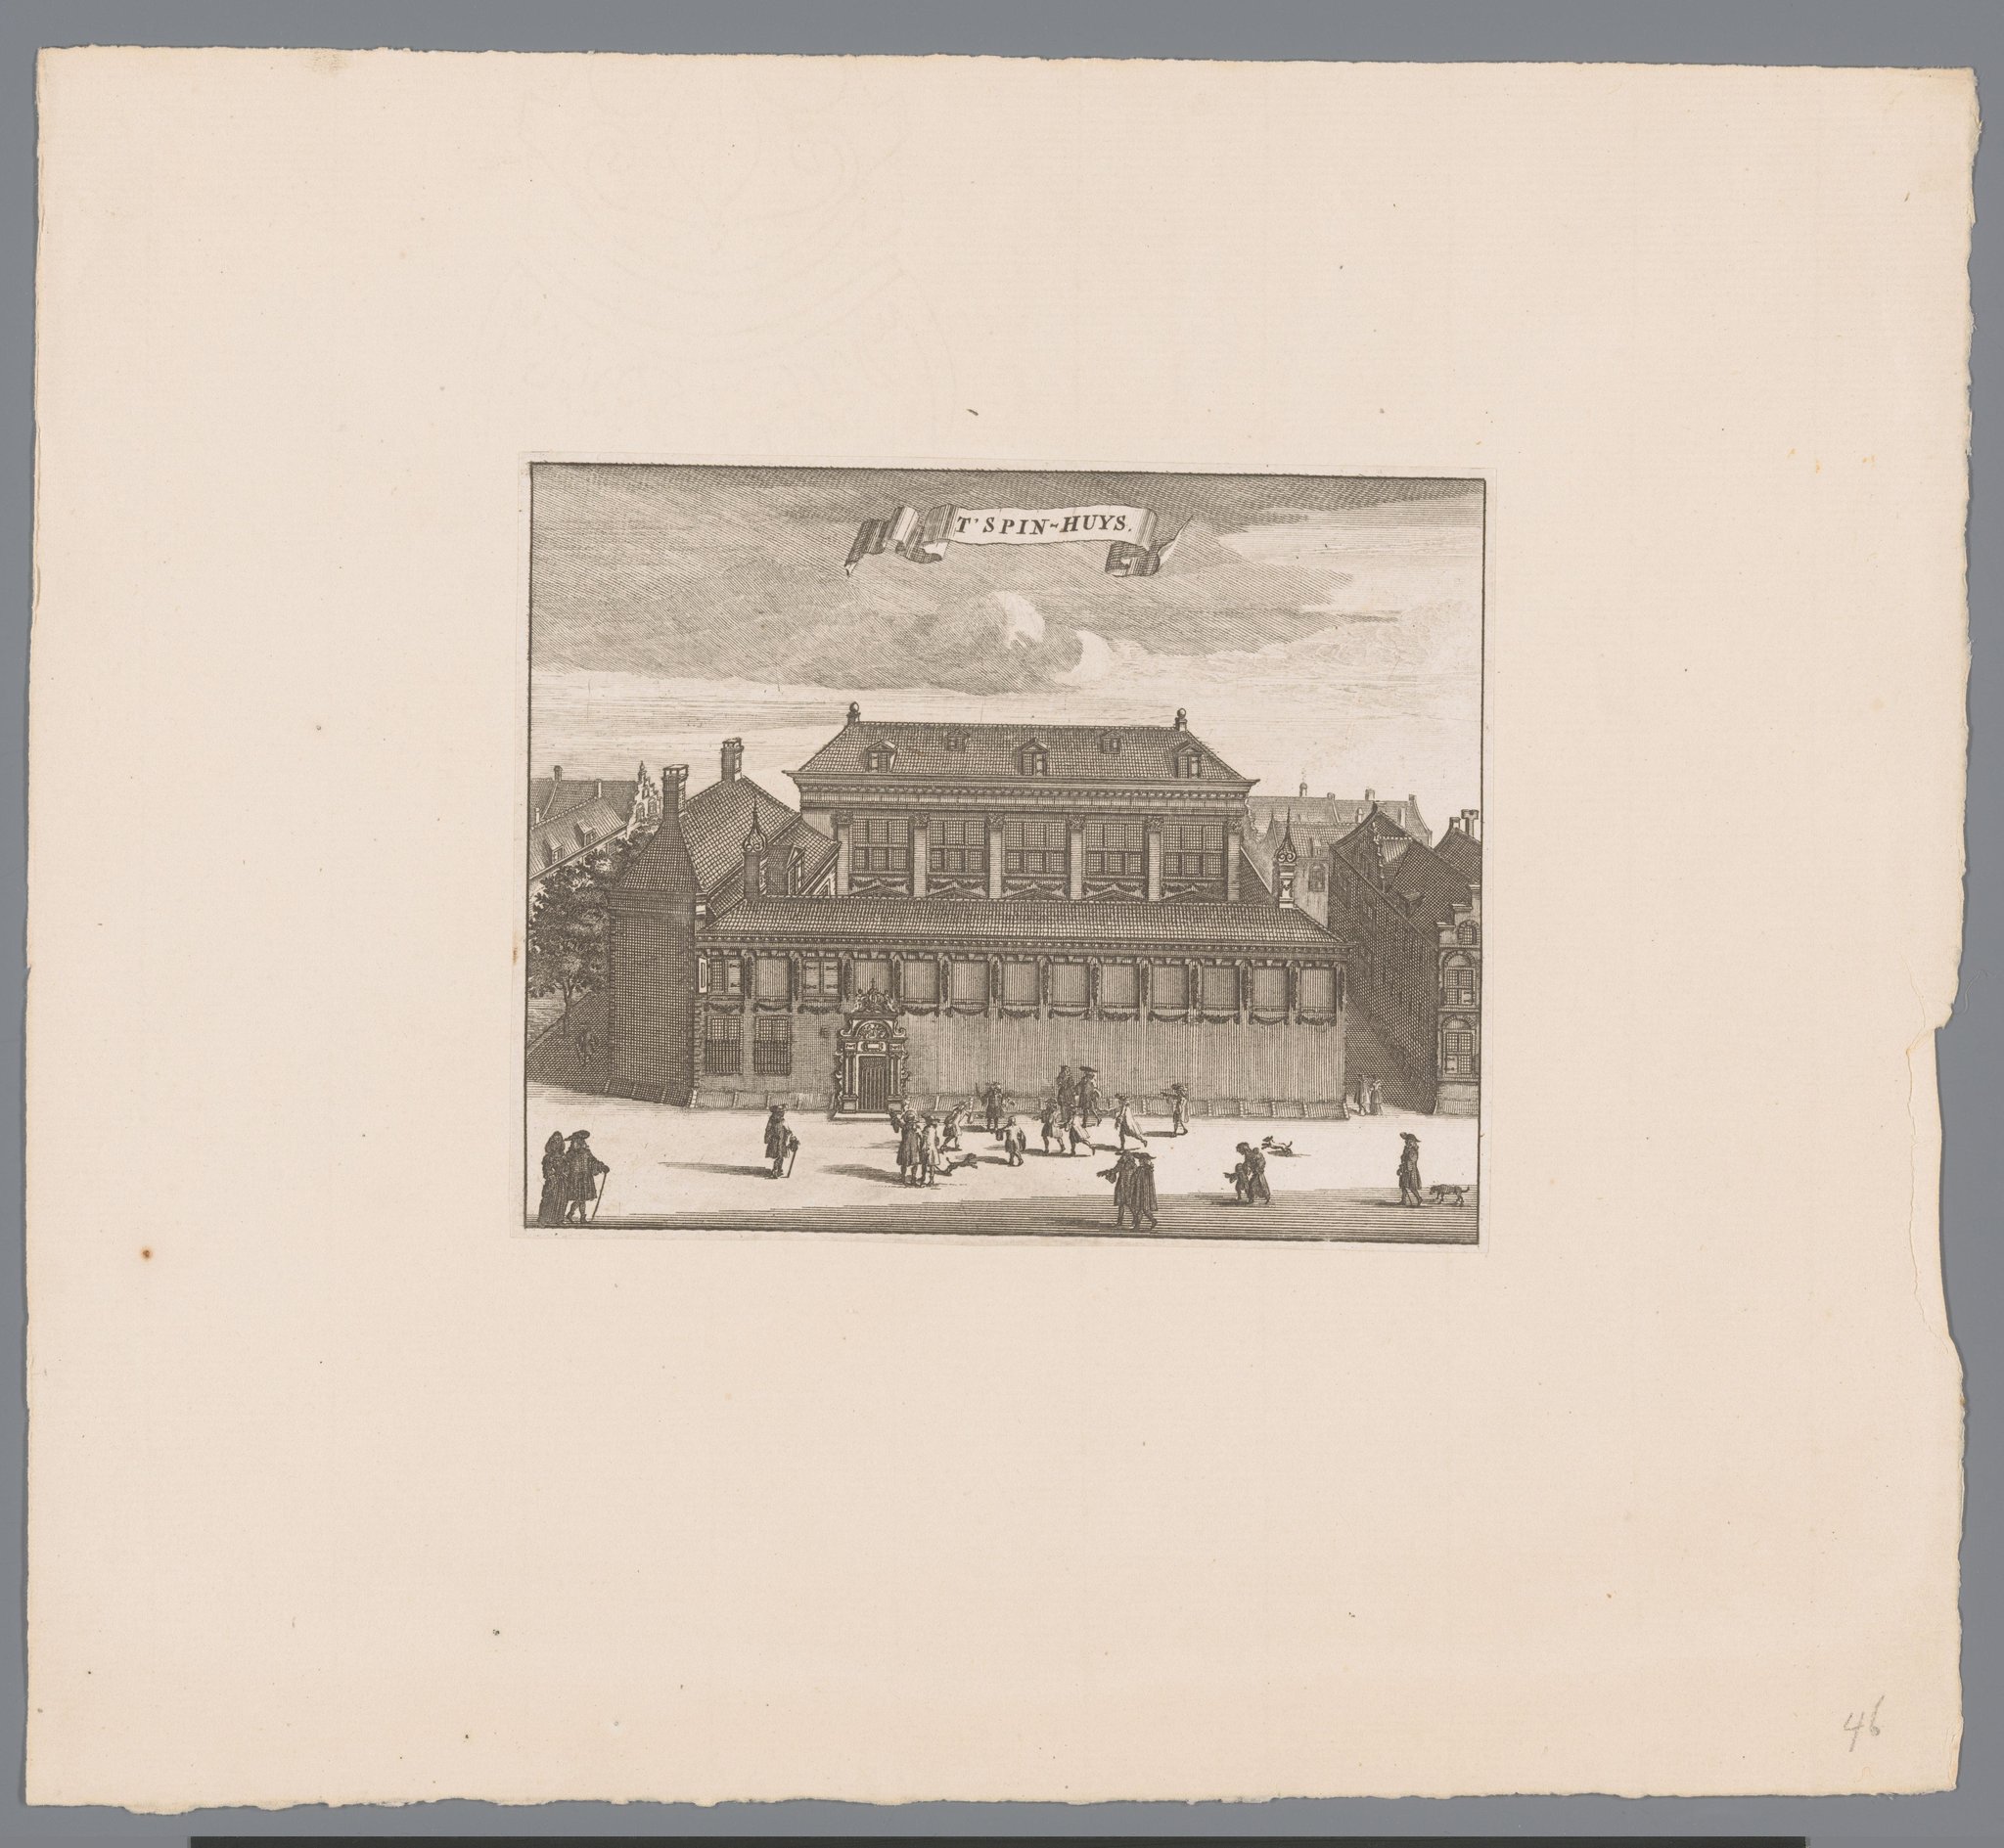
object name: print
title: Gezicht op het Spinhuis te Amsterdam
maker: Anonymous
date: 1693-1694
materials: paper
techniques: etching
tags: prison, jail, gate, entrance, workhouse, penal camp, penitentiary, chain gang, street (+ city(-scape) with figures, staffage)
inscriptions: watermark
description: Prent verschenen in: Commelin, Caspar. Beschryvinge van Amsterdam, desselfs eerste oorspronk uyt den Huyse (…). 2 dln. Amsterdam: Abraham Wolfgang et al., 1693. Of in: Commelin, Caspar. Beschryvinge van Amsterdam, zynde een naukeurige verhandelinge van desselfs eerste oorspronk uyt (…). 2 dln. Amsterdam: weduwe Aart Dircksz Oossaan, 1694. Of in: Commelin, Caspar. Beschryvinge van Amsterdam, zynde een naukeurige verhandelinge van desselfs eerste oorspronk uyt (…). 2 dln. 2e druk. Amsterdam: Andries van Damme et al., 1726.